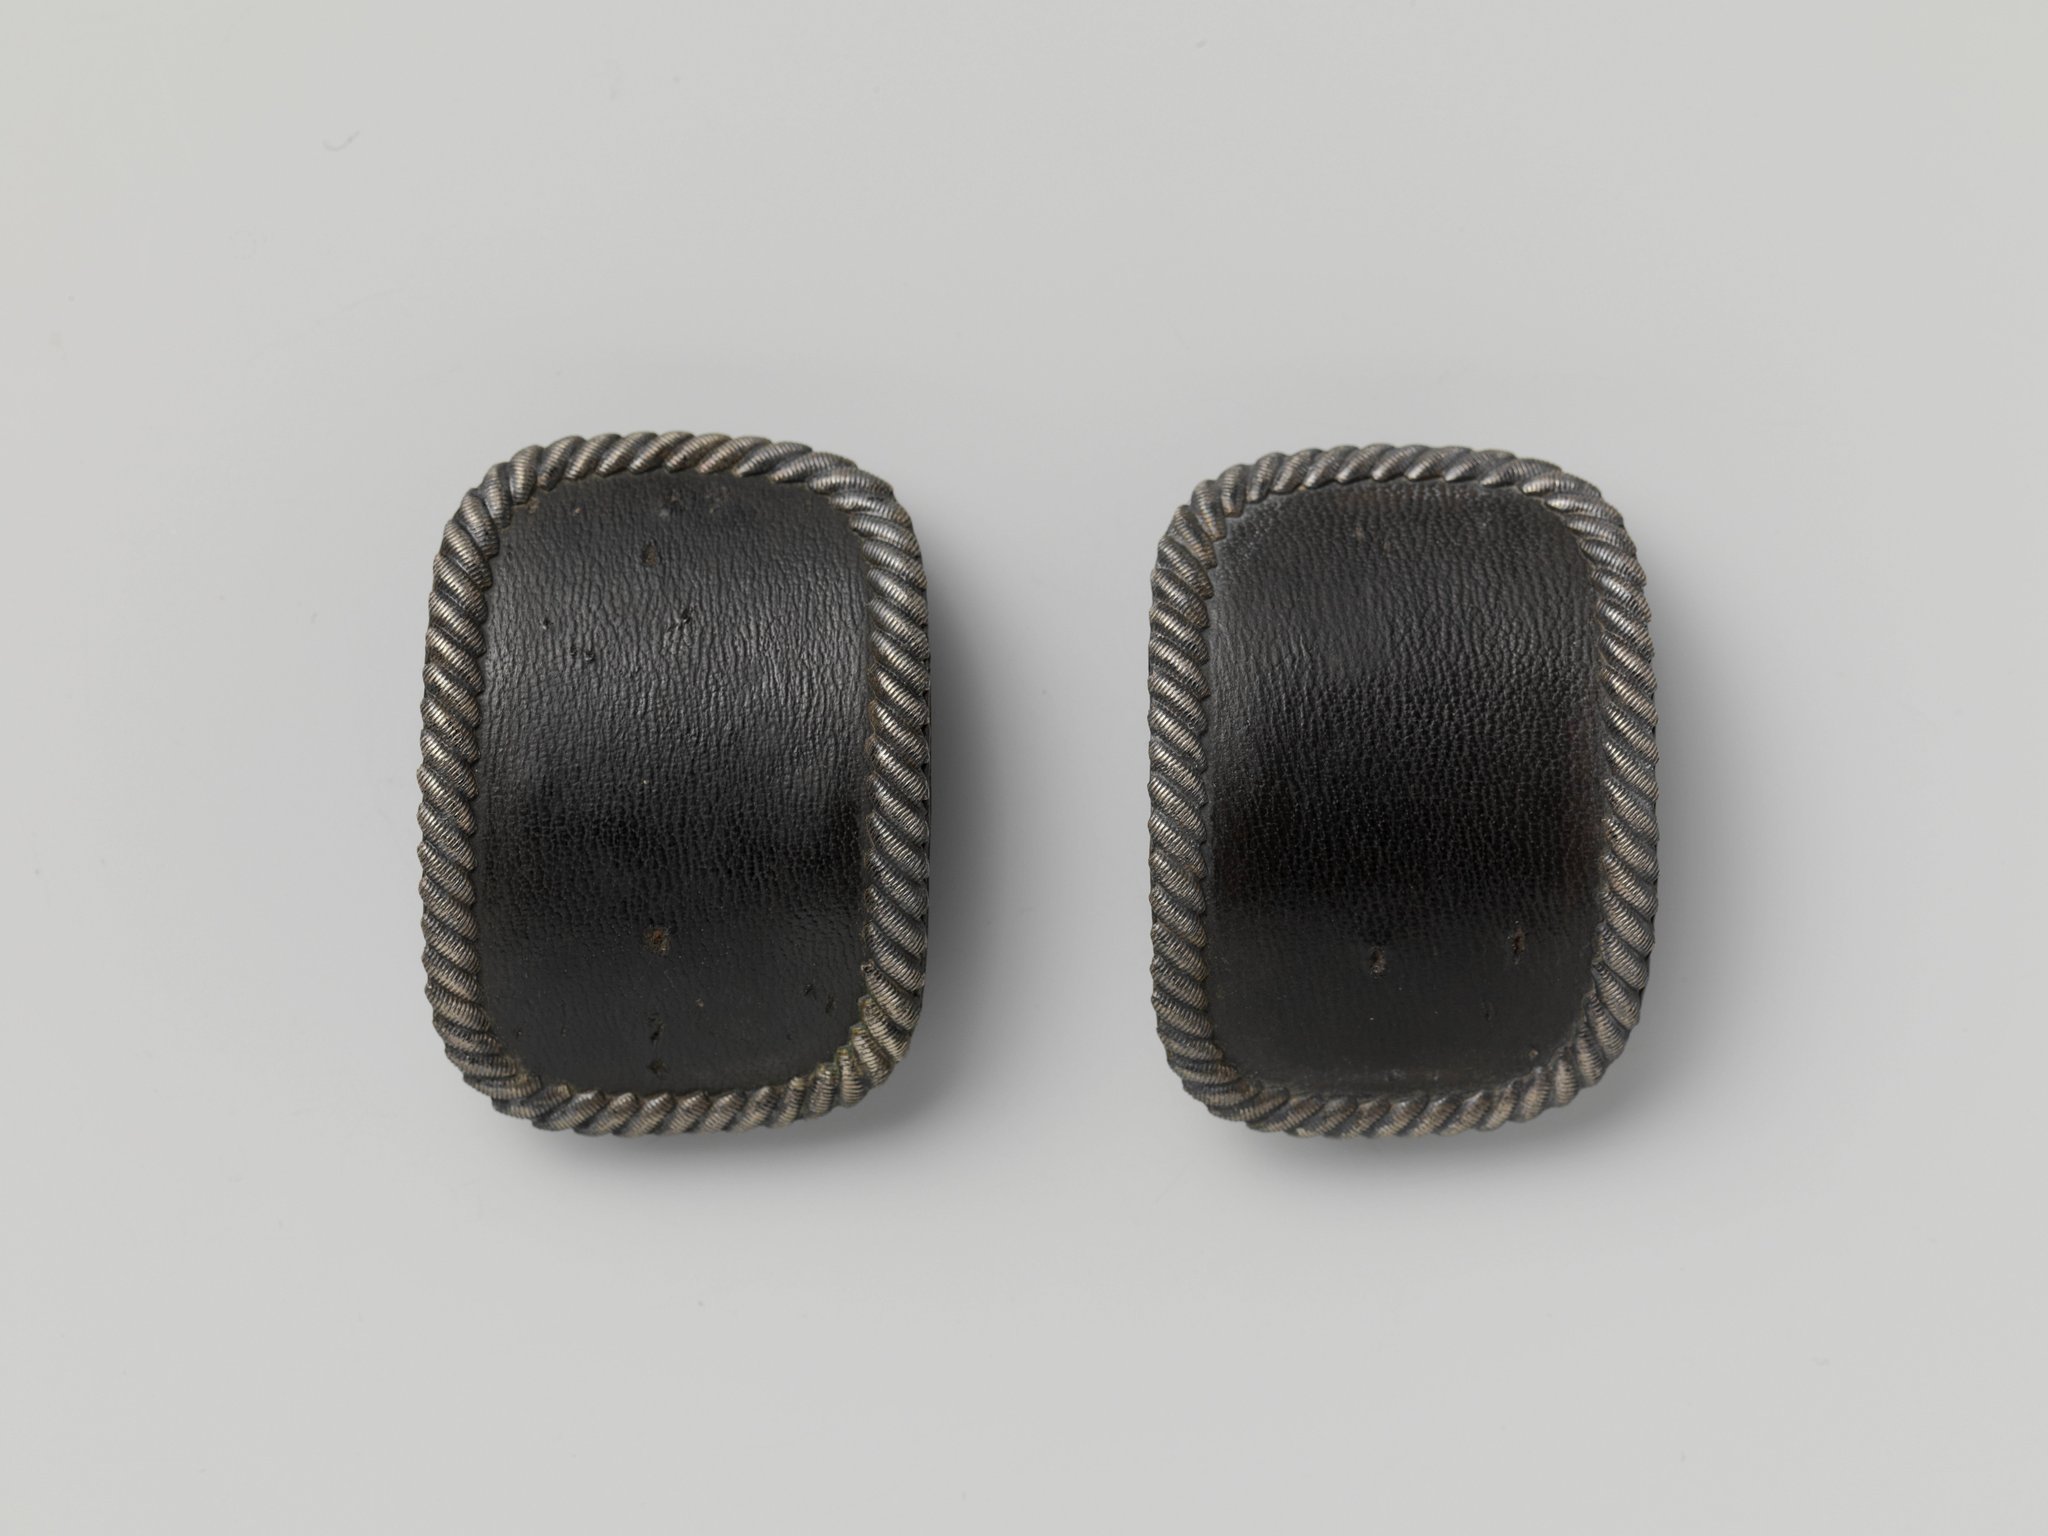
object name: clothing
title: Schoengesp van ijzer, rechthoekig model met afgeronde metalen hoeken en een zwart leren middendeel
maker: Anonymous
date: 1800-1900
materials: iron, leather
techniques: forging, tanning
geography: great britain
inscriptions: inscription: ‘'Shoe patent'’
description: Schoengesp van ijzer, rechthoekig model met afgeronde metalen hoeken en een zwart leren middendeel. Een aaneengeschakelde gearceerde ijzeren rand. De gesp bestaat uit vier tanden aan een gebogen metalen plaat. Onderop staat: 'Shoe patent'.